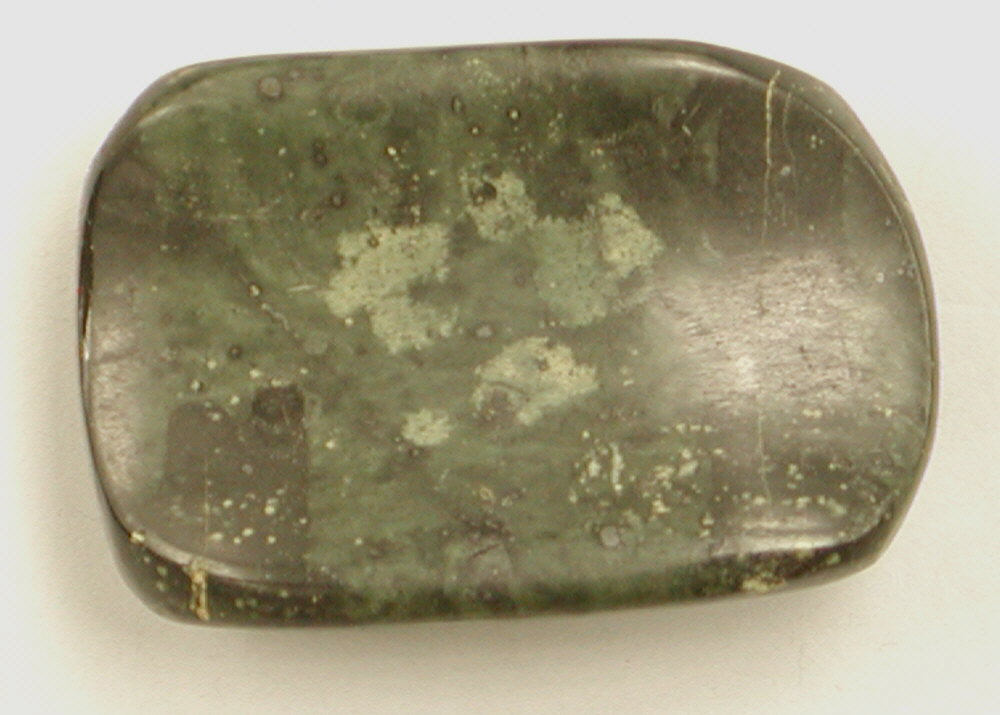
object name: pendant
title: Stone Pendant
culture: mezcala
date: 1-800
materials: stone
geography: mexico